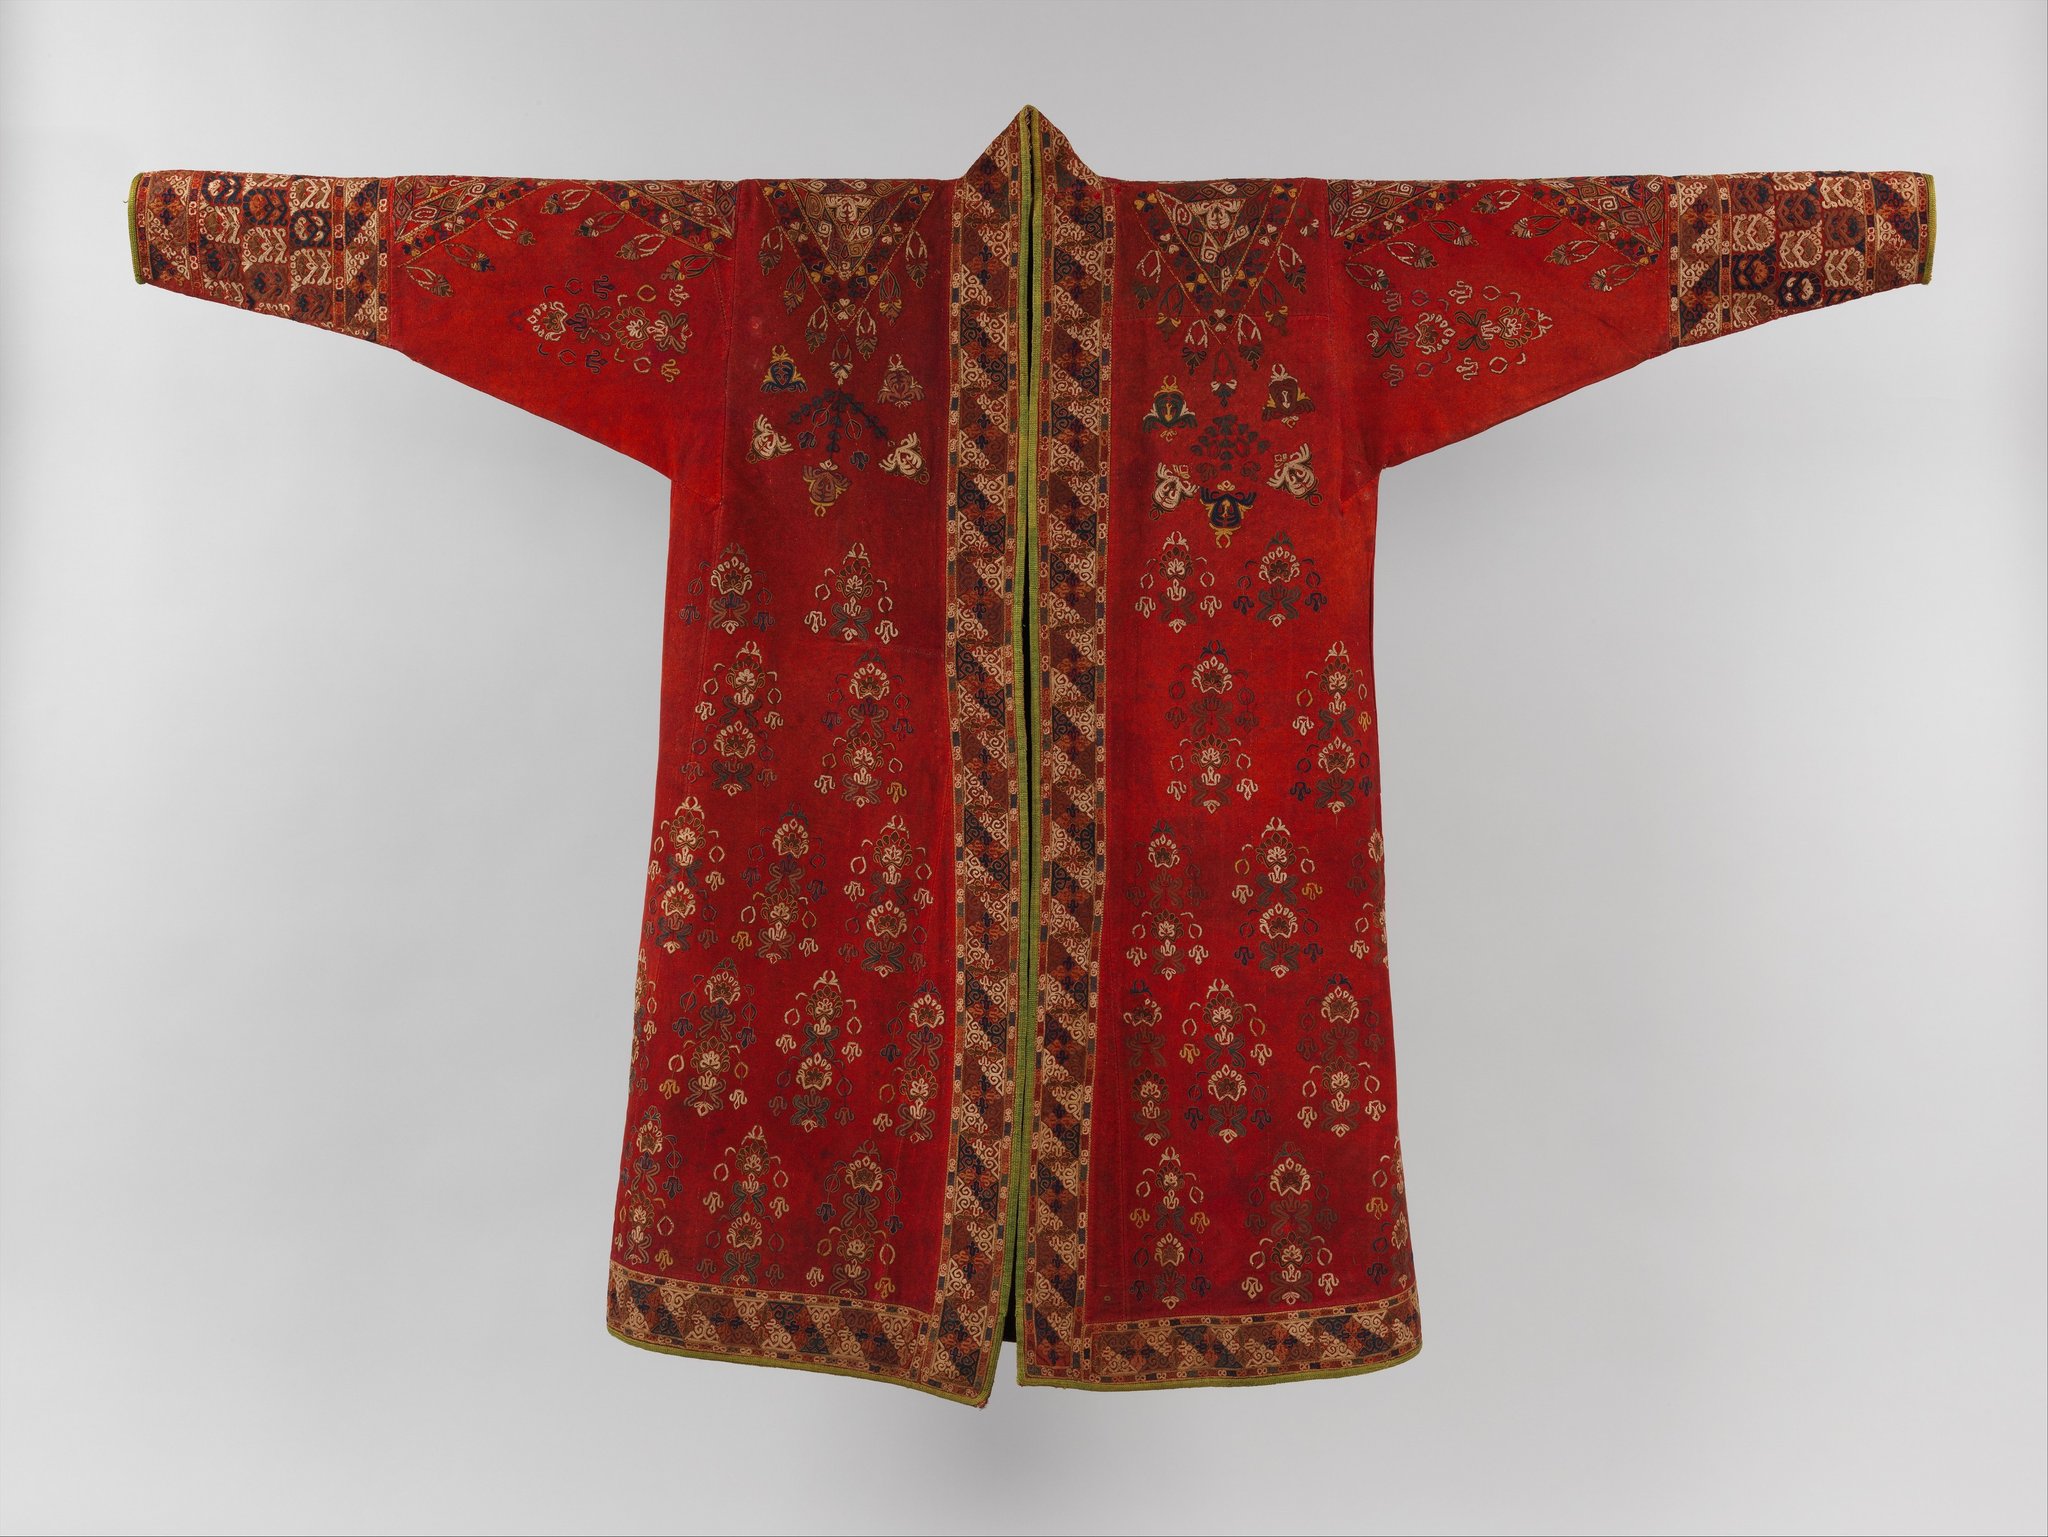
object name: coat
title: Coat (Choga)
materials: cotton, silk, wool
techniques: embroidery, lining, weave, printing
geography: turkmenistan